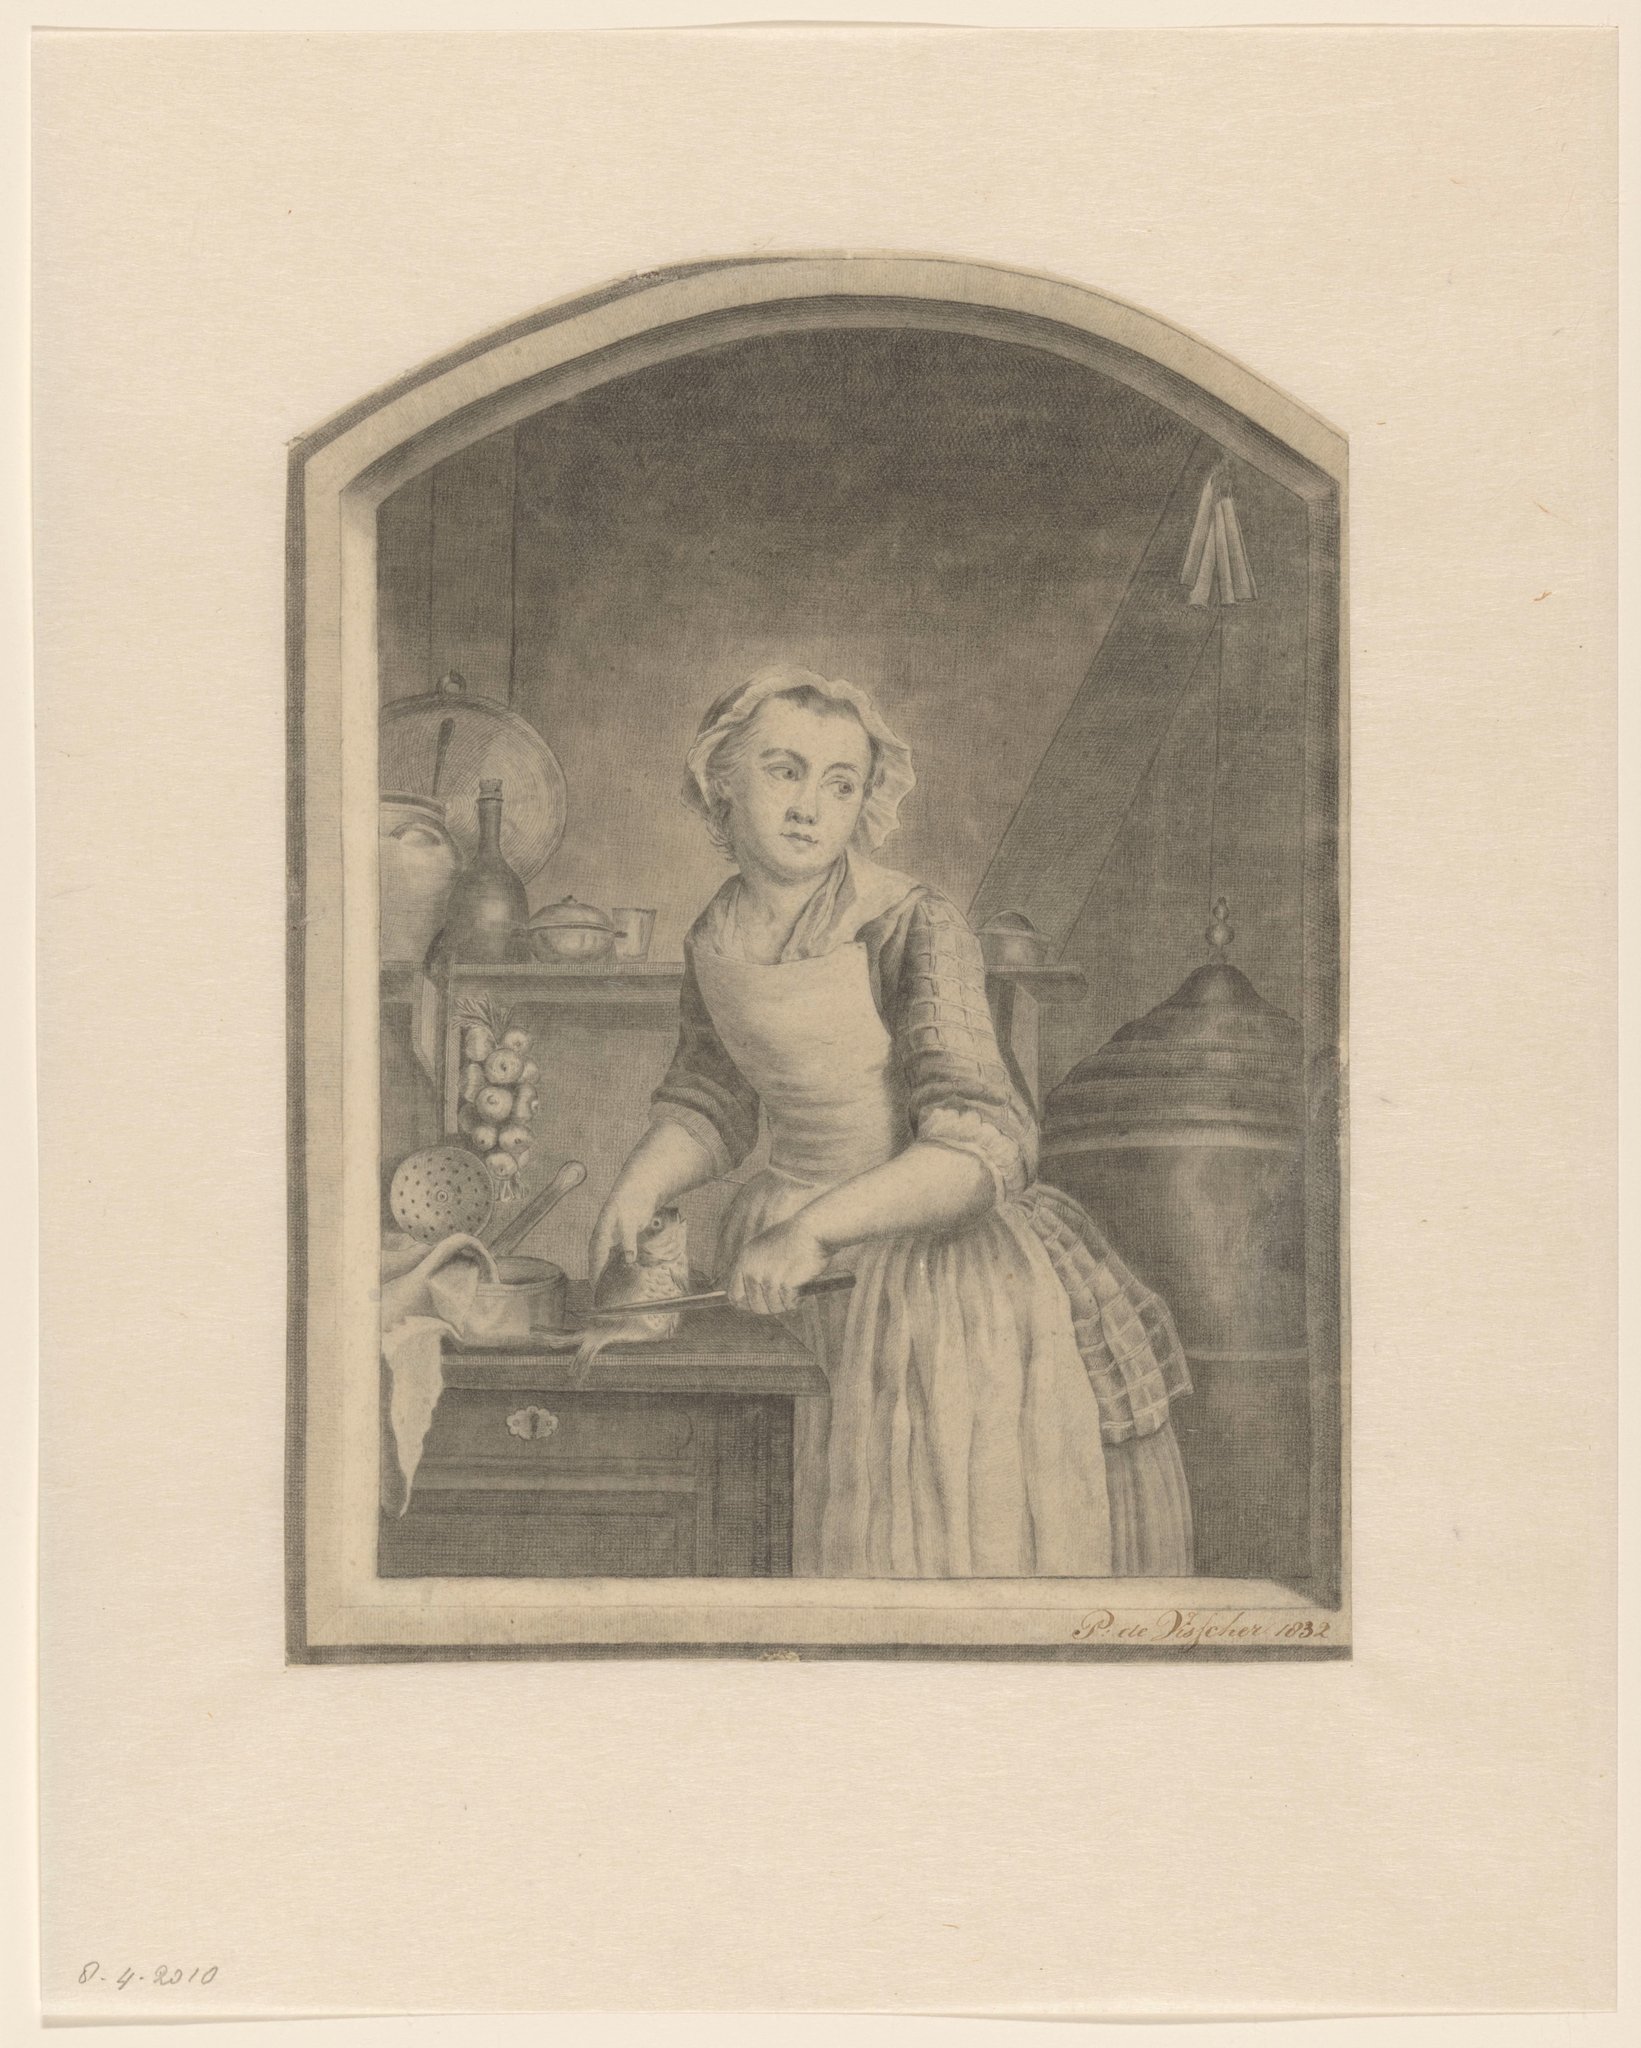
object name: drawing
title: Keukenmeid die vis schoonmaakt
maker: p. de visscher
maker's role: draughtsman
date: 1832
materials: paper, pencil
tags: kitchen